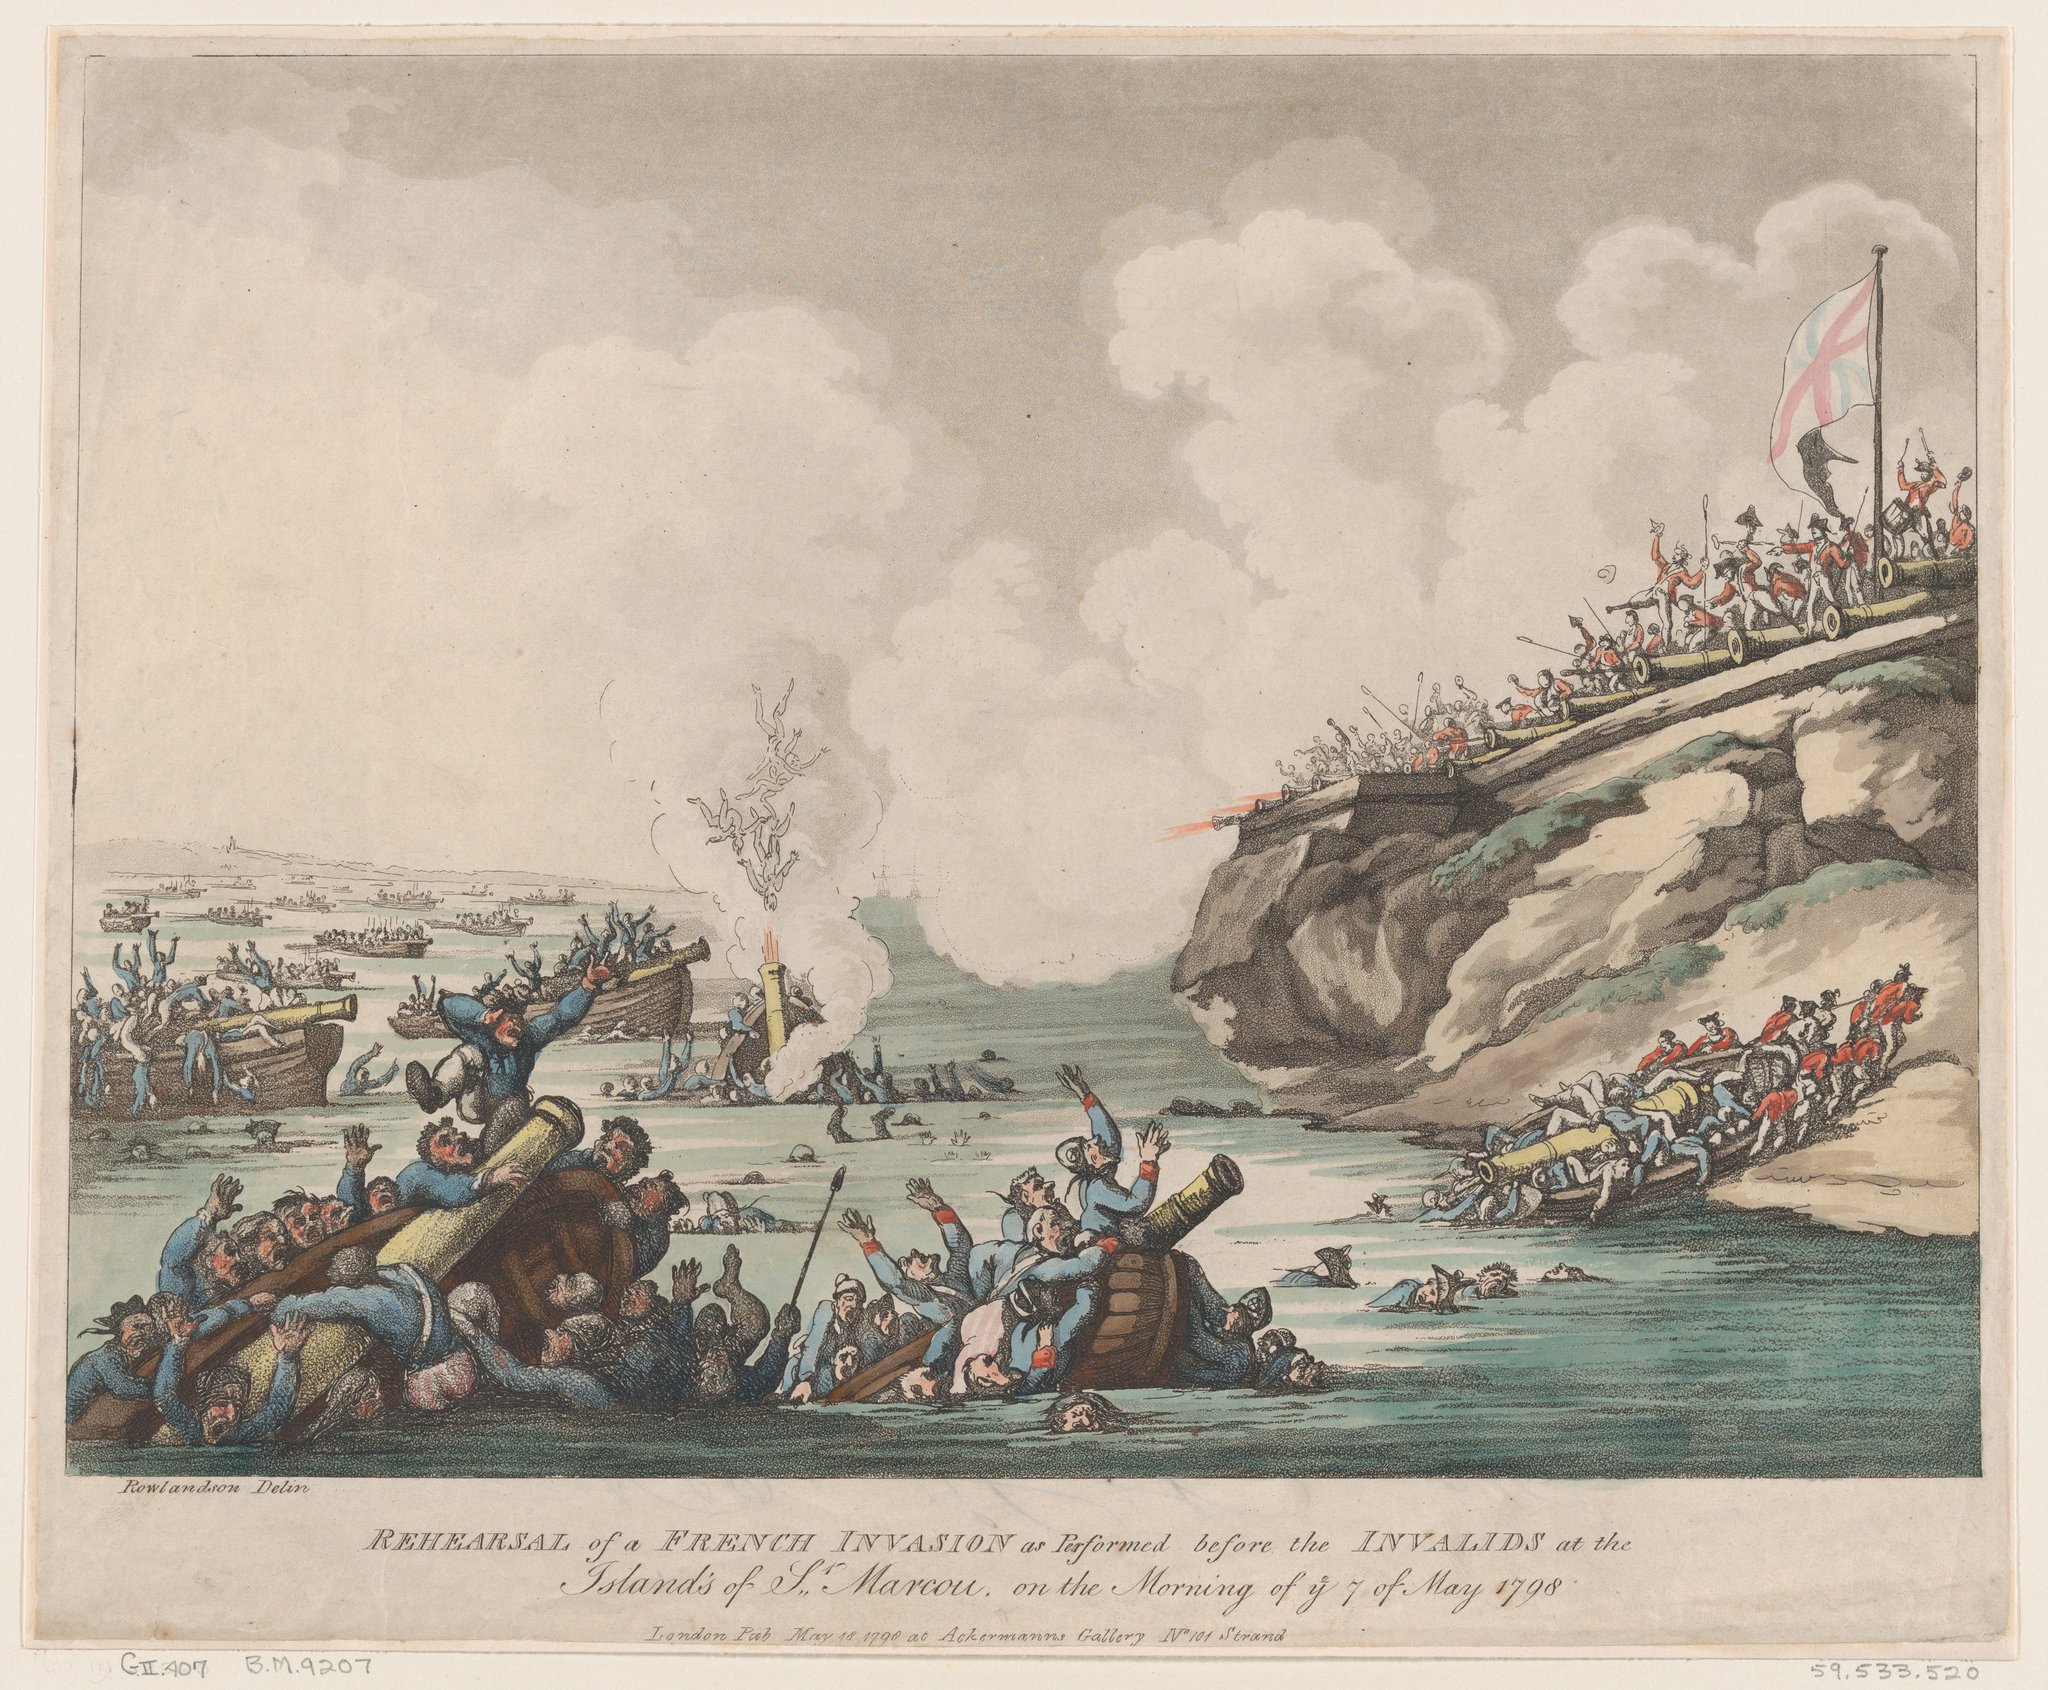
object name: print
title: Rehearsal of a French Invasion as Performed before the Invalids at the Islands of St Marcou on the Morning of the 7th of May 1798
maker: thomas rowlandson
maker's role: artist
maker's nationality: british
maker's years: 1757-1827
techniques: aquatint, etching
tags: battles,cannons,men,boats